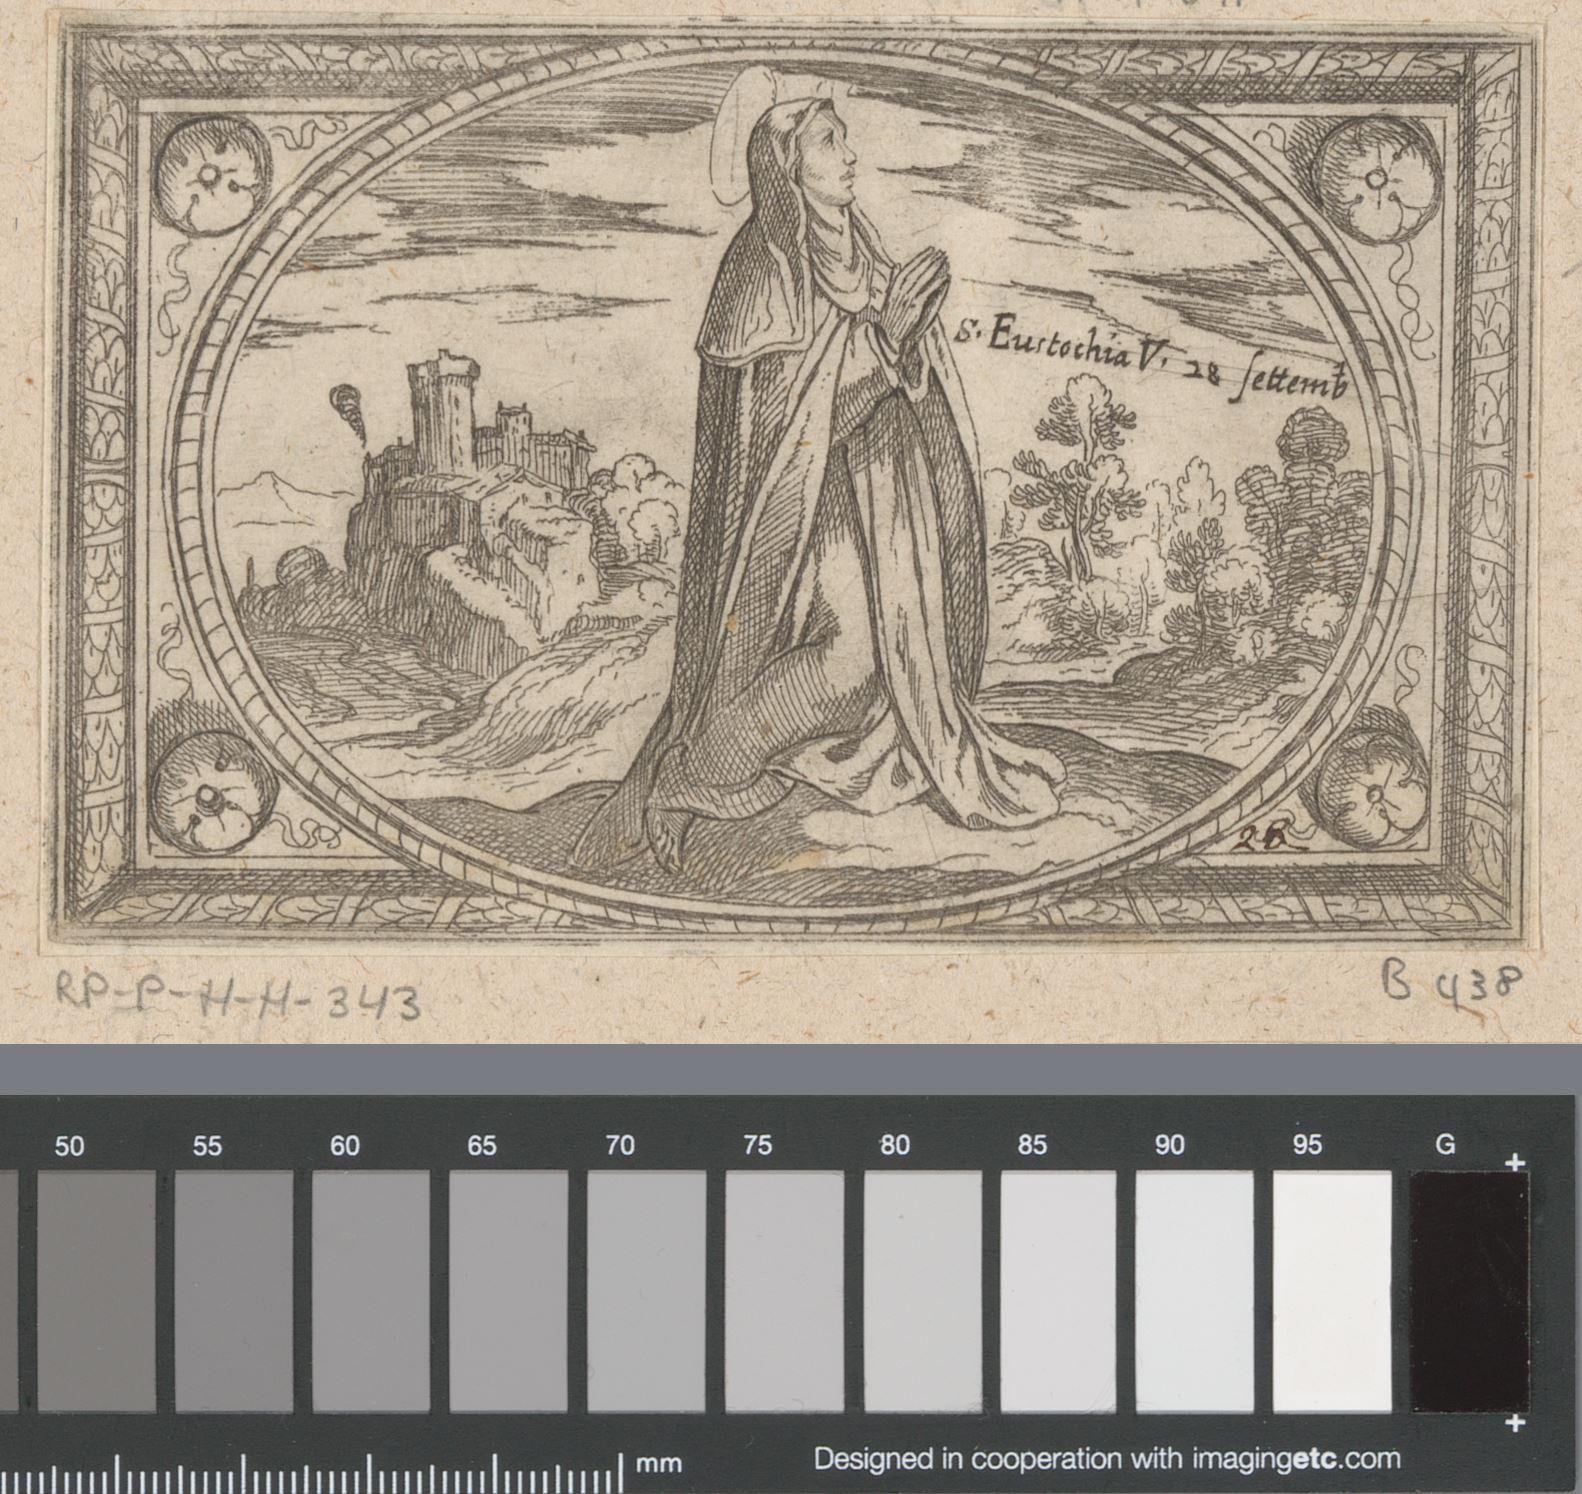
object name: print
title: Imagini di moltes vergini Rom nel martirio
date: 1565-1630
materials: paper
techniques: etching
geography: rome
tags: martyr(s) (often with palm-branches) - qq - female martyr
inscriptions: number: ‘28’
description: Deze prent maakt deel uit van een reeks van 73 prenten (+ titelprent) met voorstellingen van Romeinse martelaressen.